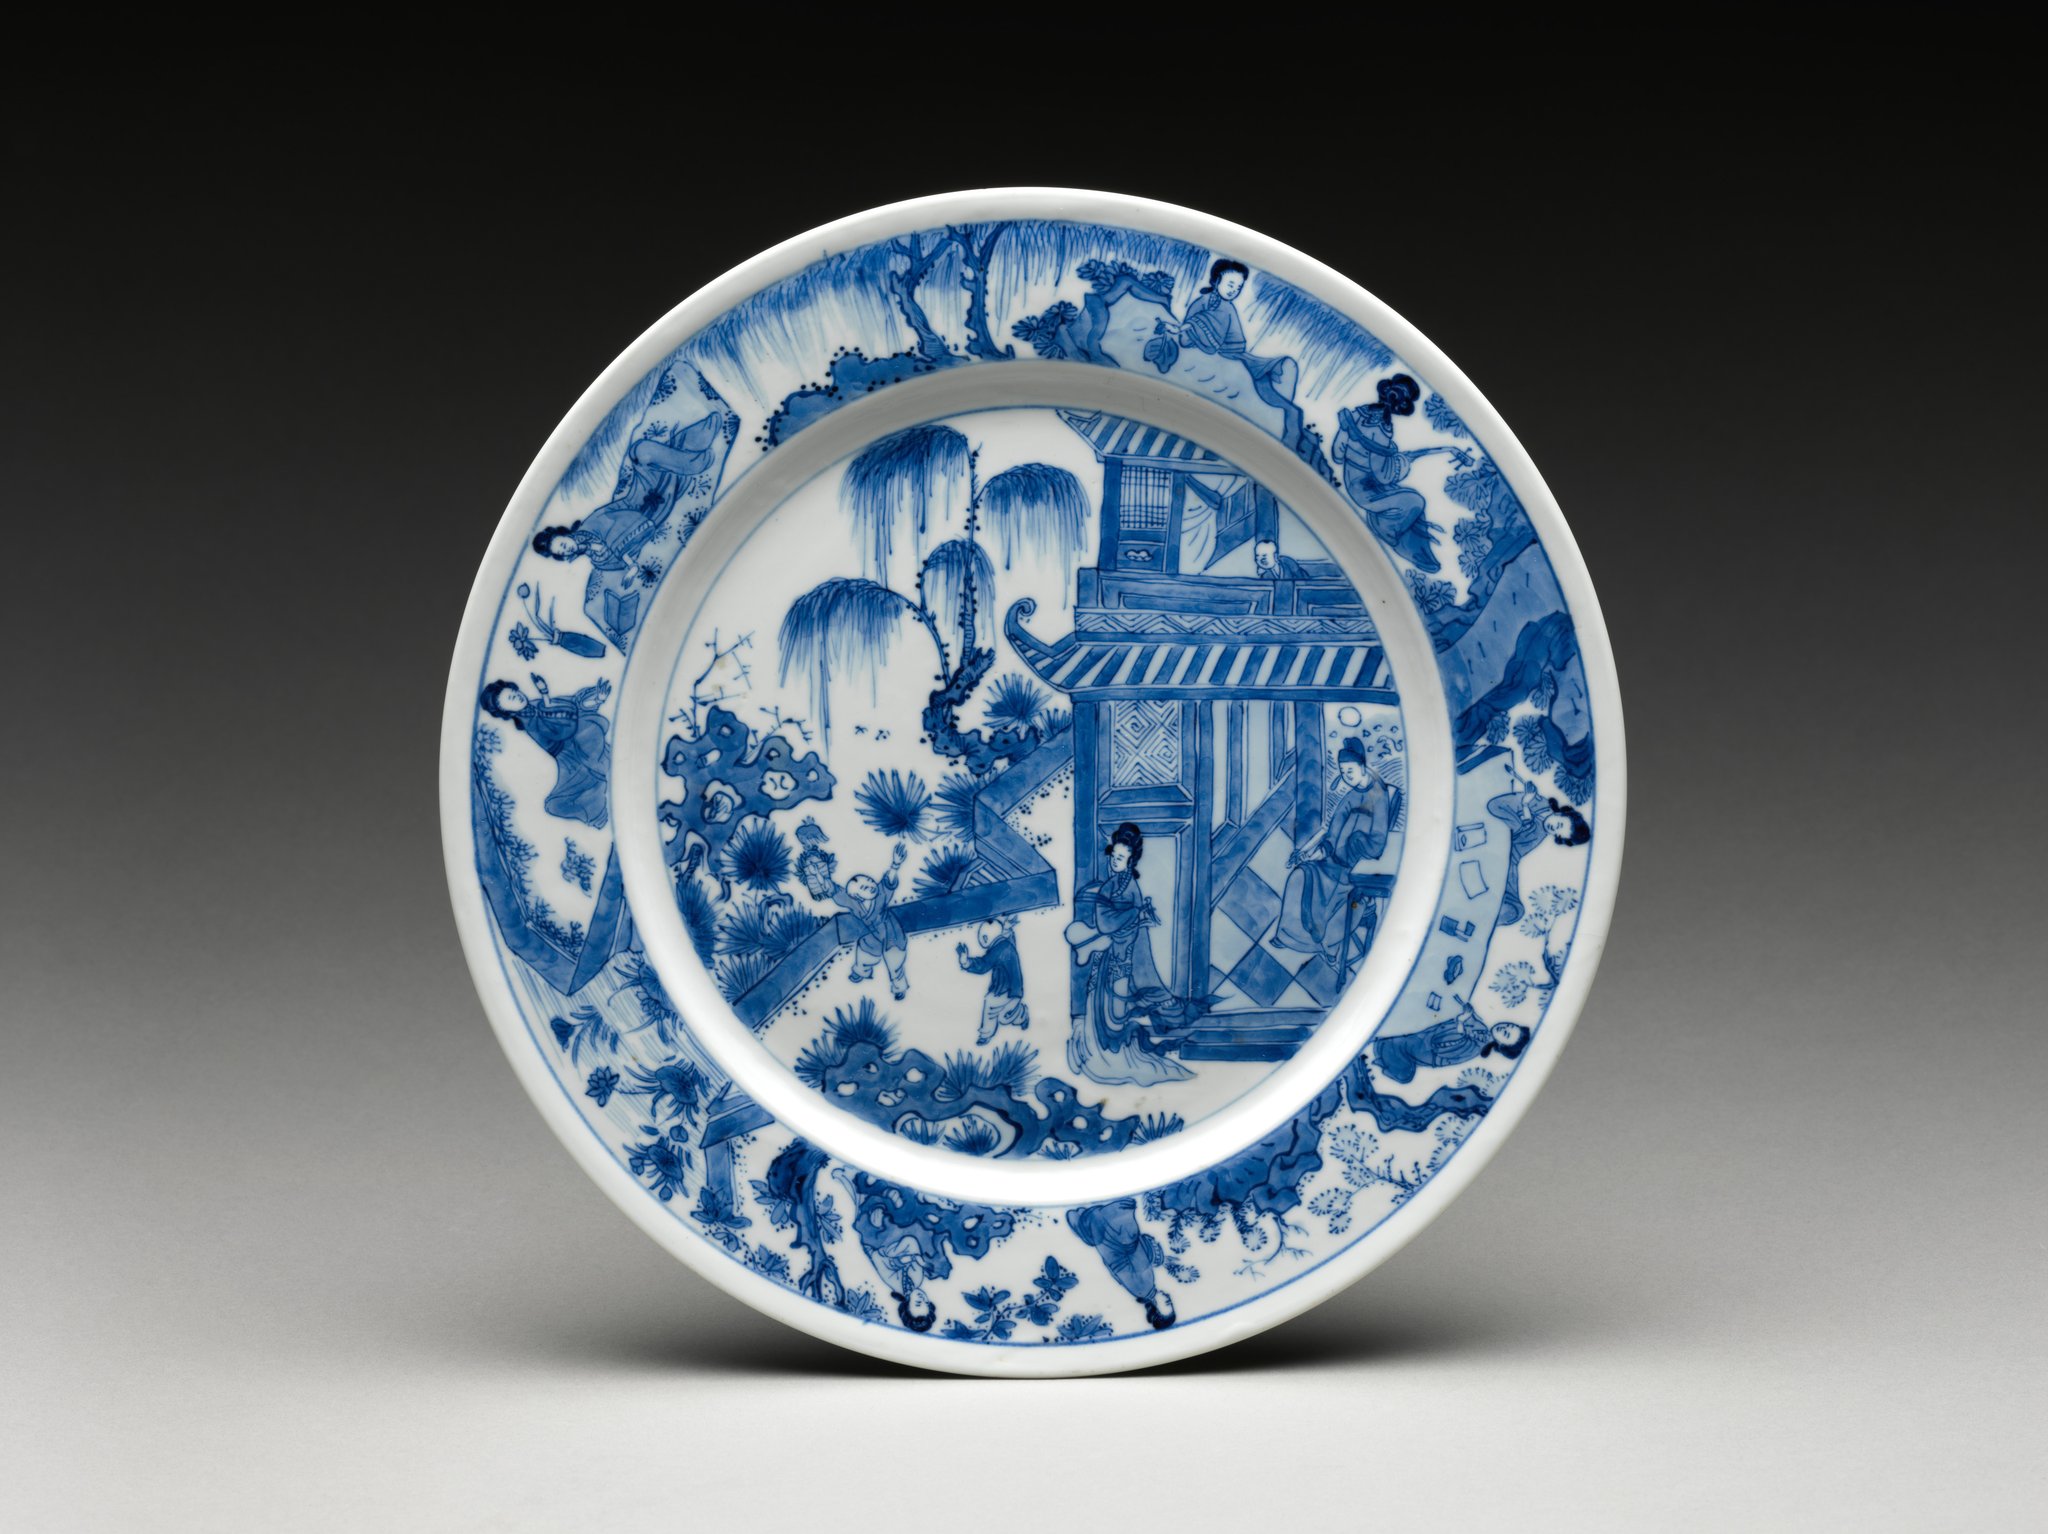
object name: dish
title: Dish with scene of a family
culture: chinese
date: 1701-1733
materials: cobalt, porcelain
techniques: painting, underglaze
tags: human figures